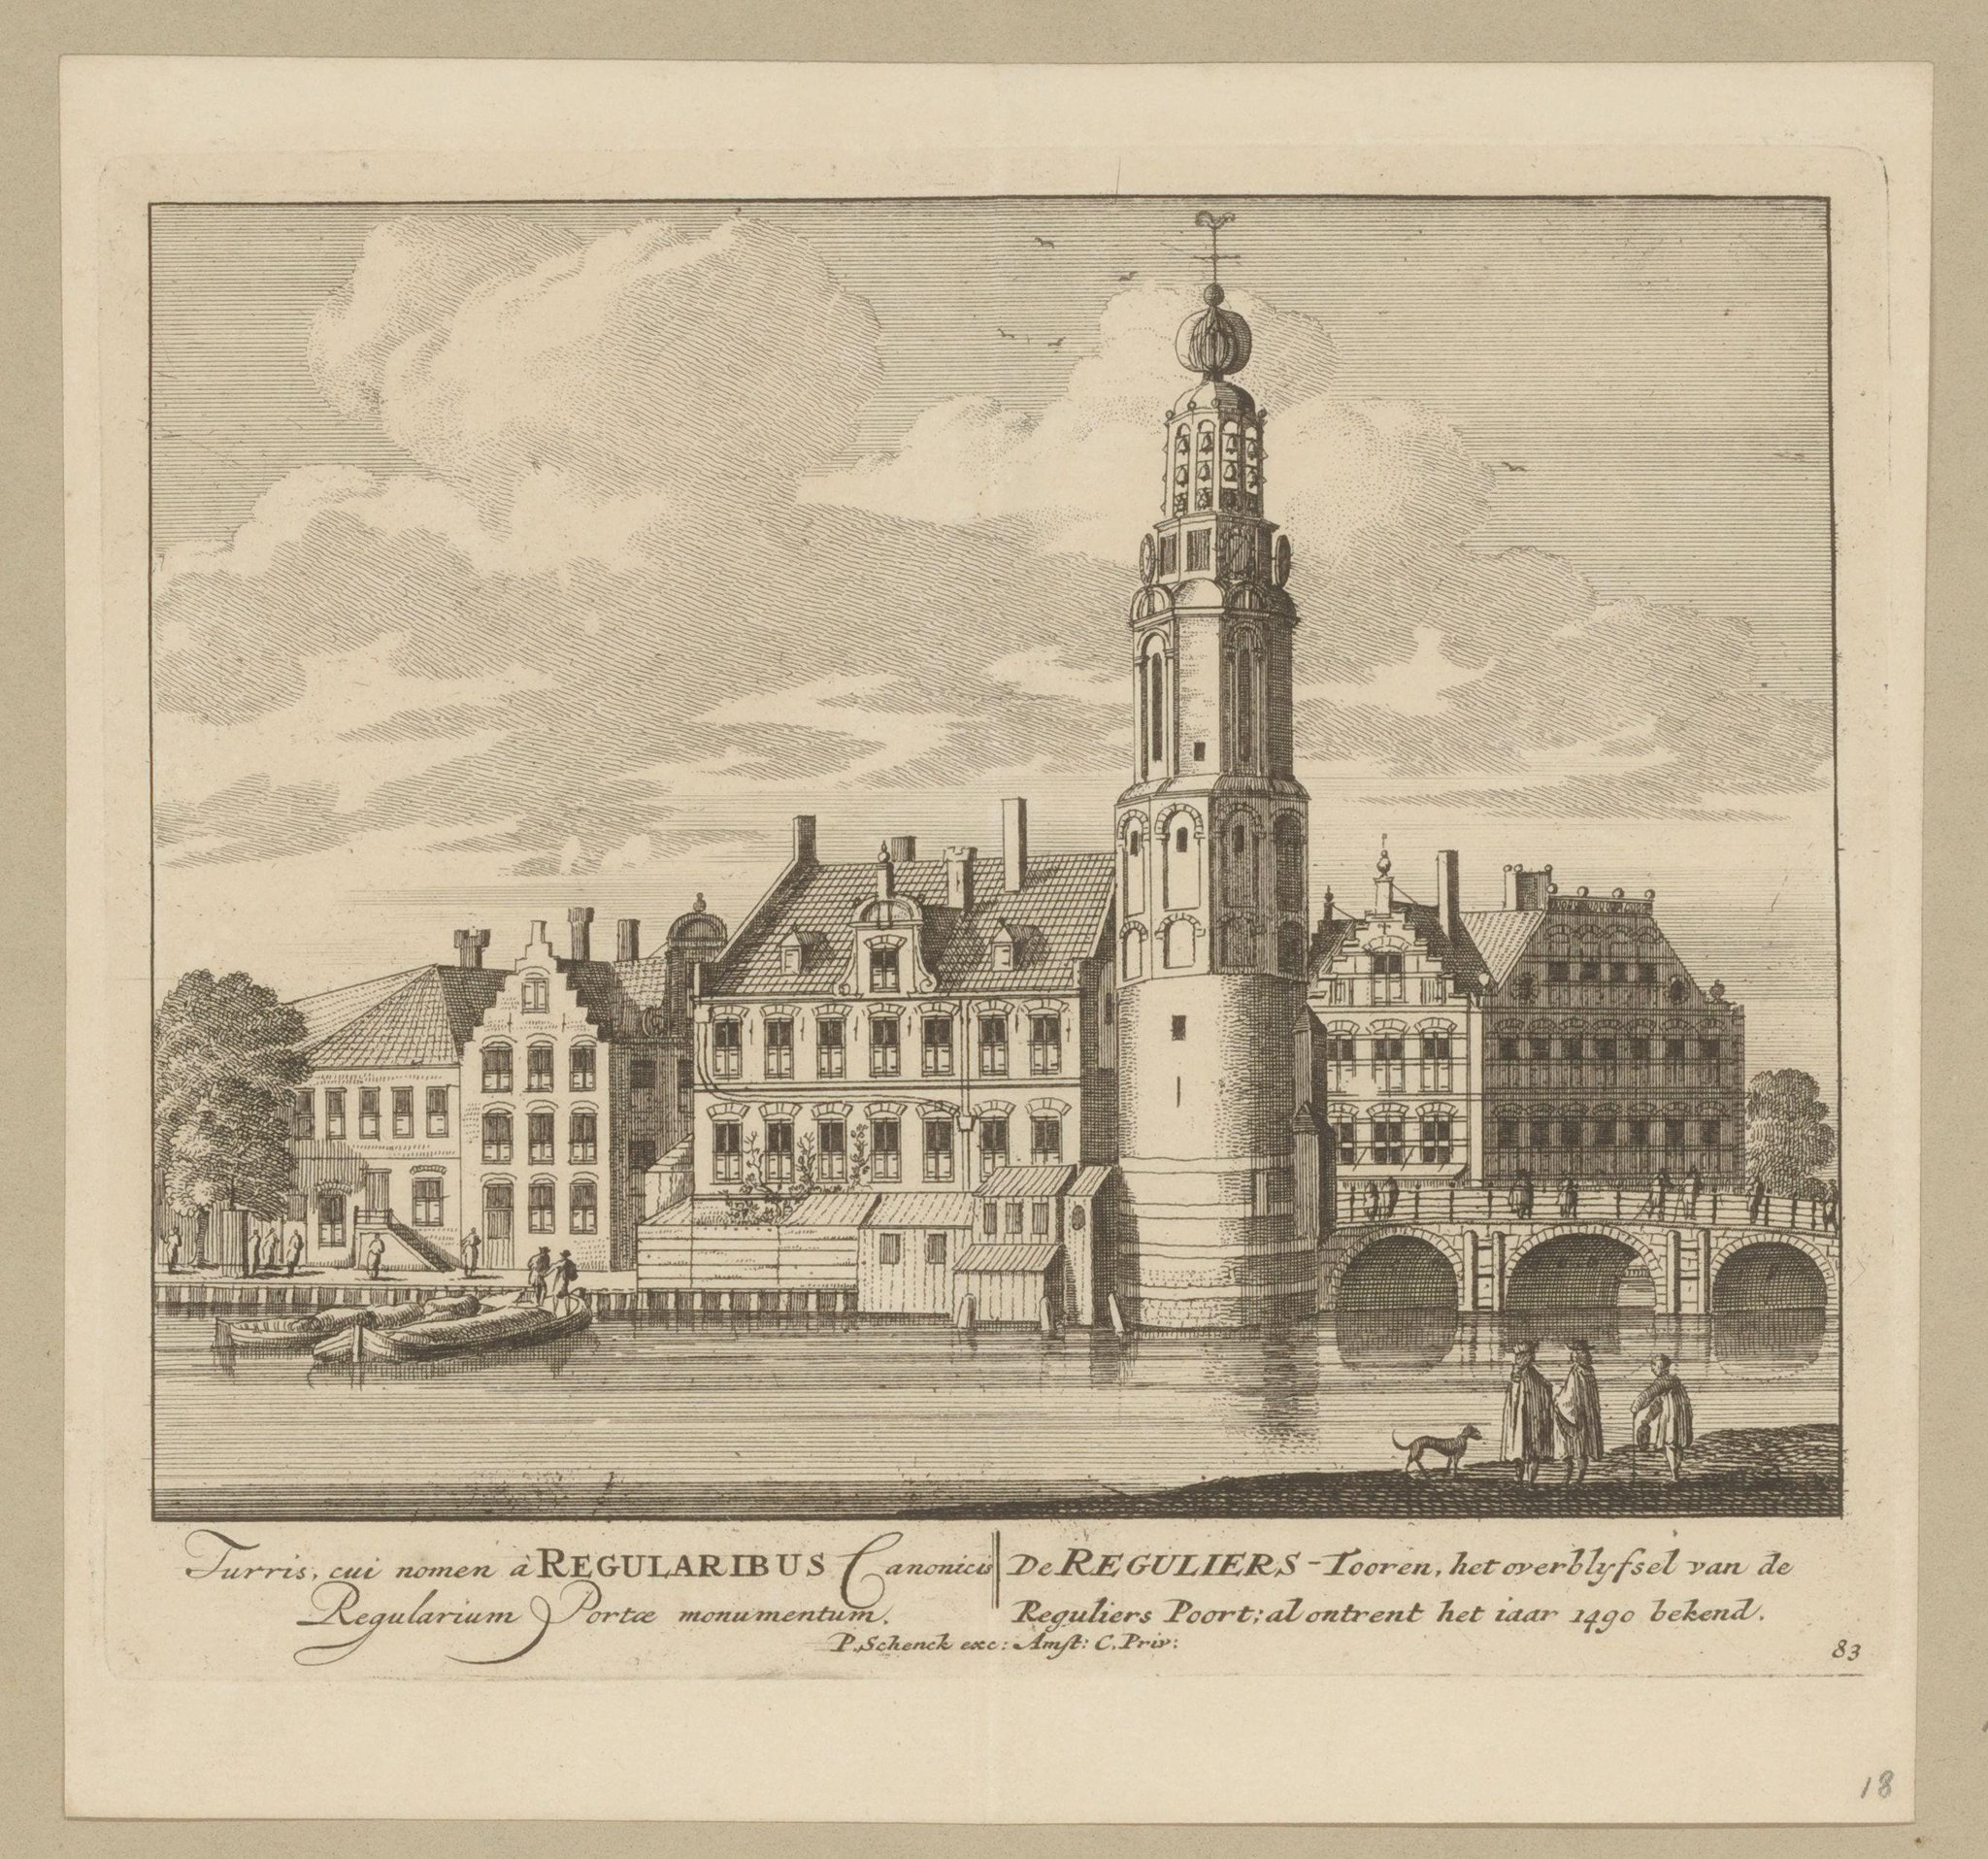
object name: print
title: Turris, cui nomen à Regularibus Canonicis Regularium Portae monumentum / De Reguliers-Tooren, het overblyfsel van de Reguliers Poort; al ontrent het iaar 1490 bekend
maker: Anonymous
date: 1710-1711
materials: paper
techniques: engraving, etching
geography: northern netherlands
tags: bridge in city across river, canal, etc. (+ city(-scape) with figures, staffage), tower, clock tower ~ monumental adornment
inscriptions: collector's mark: Lugt 1641b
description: Prent mogelijk uit: 100 Afbeeldinge der voornaamste gebouwen van Amsterdam. Amsterdam: Pieter Schenk (I), s.a. [1710-1711]. Of uit: 100 Afbeeldinge der voornaamste gebouwen van Amsterdam. Amsterdam: Barent Greve, s.a. [1757-1766]. In de tweede uitgave, uitgegeven door Barent Greve, is alleen de titelprent aangepast. De overige prenten zijn onveranderd gebleven.